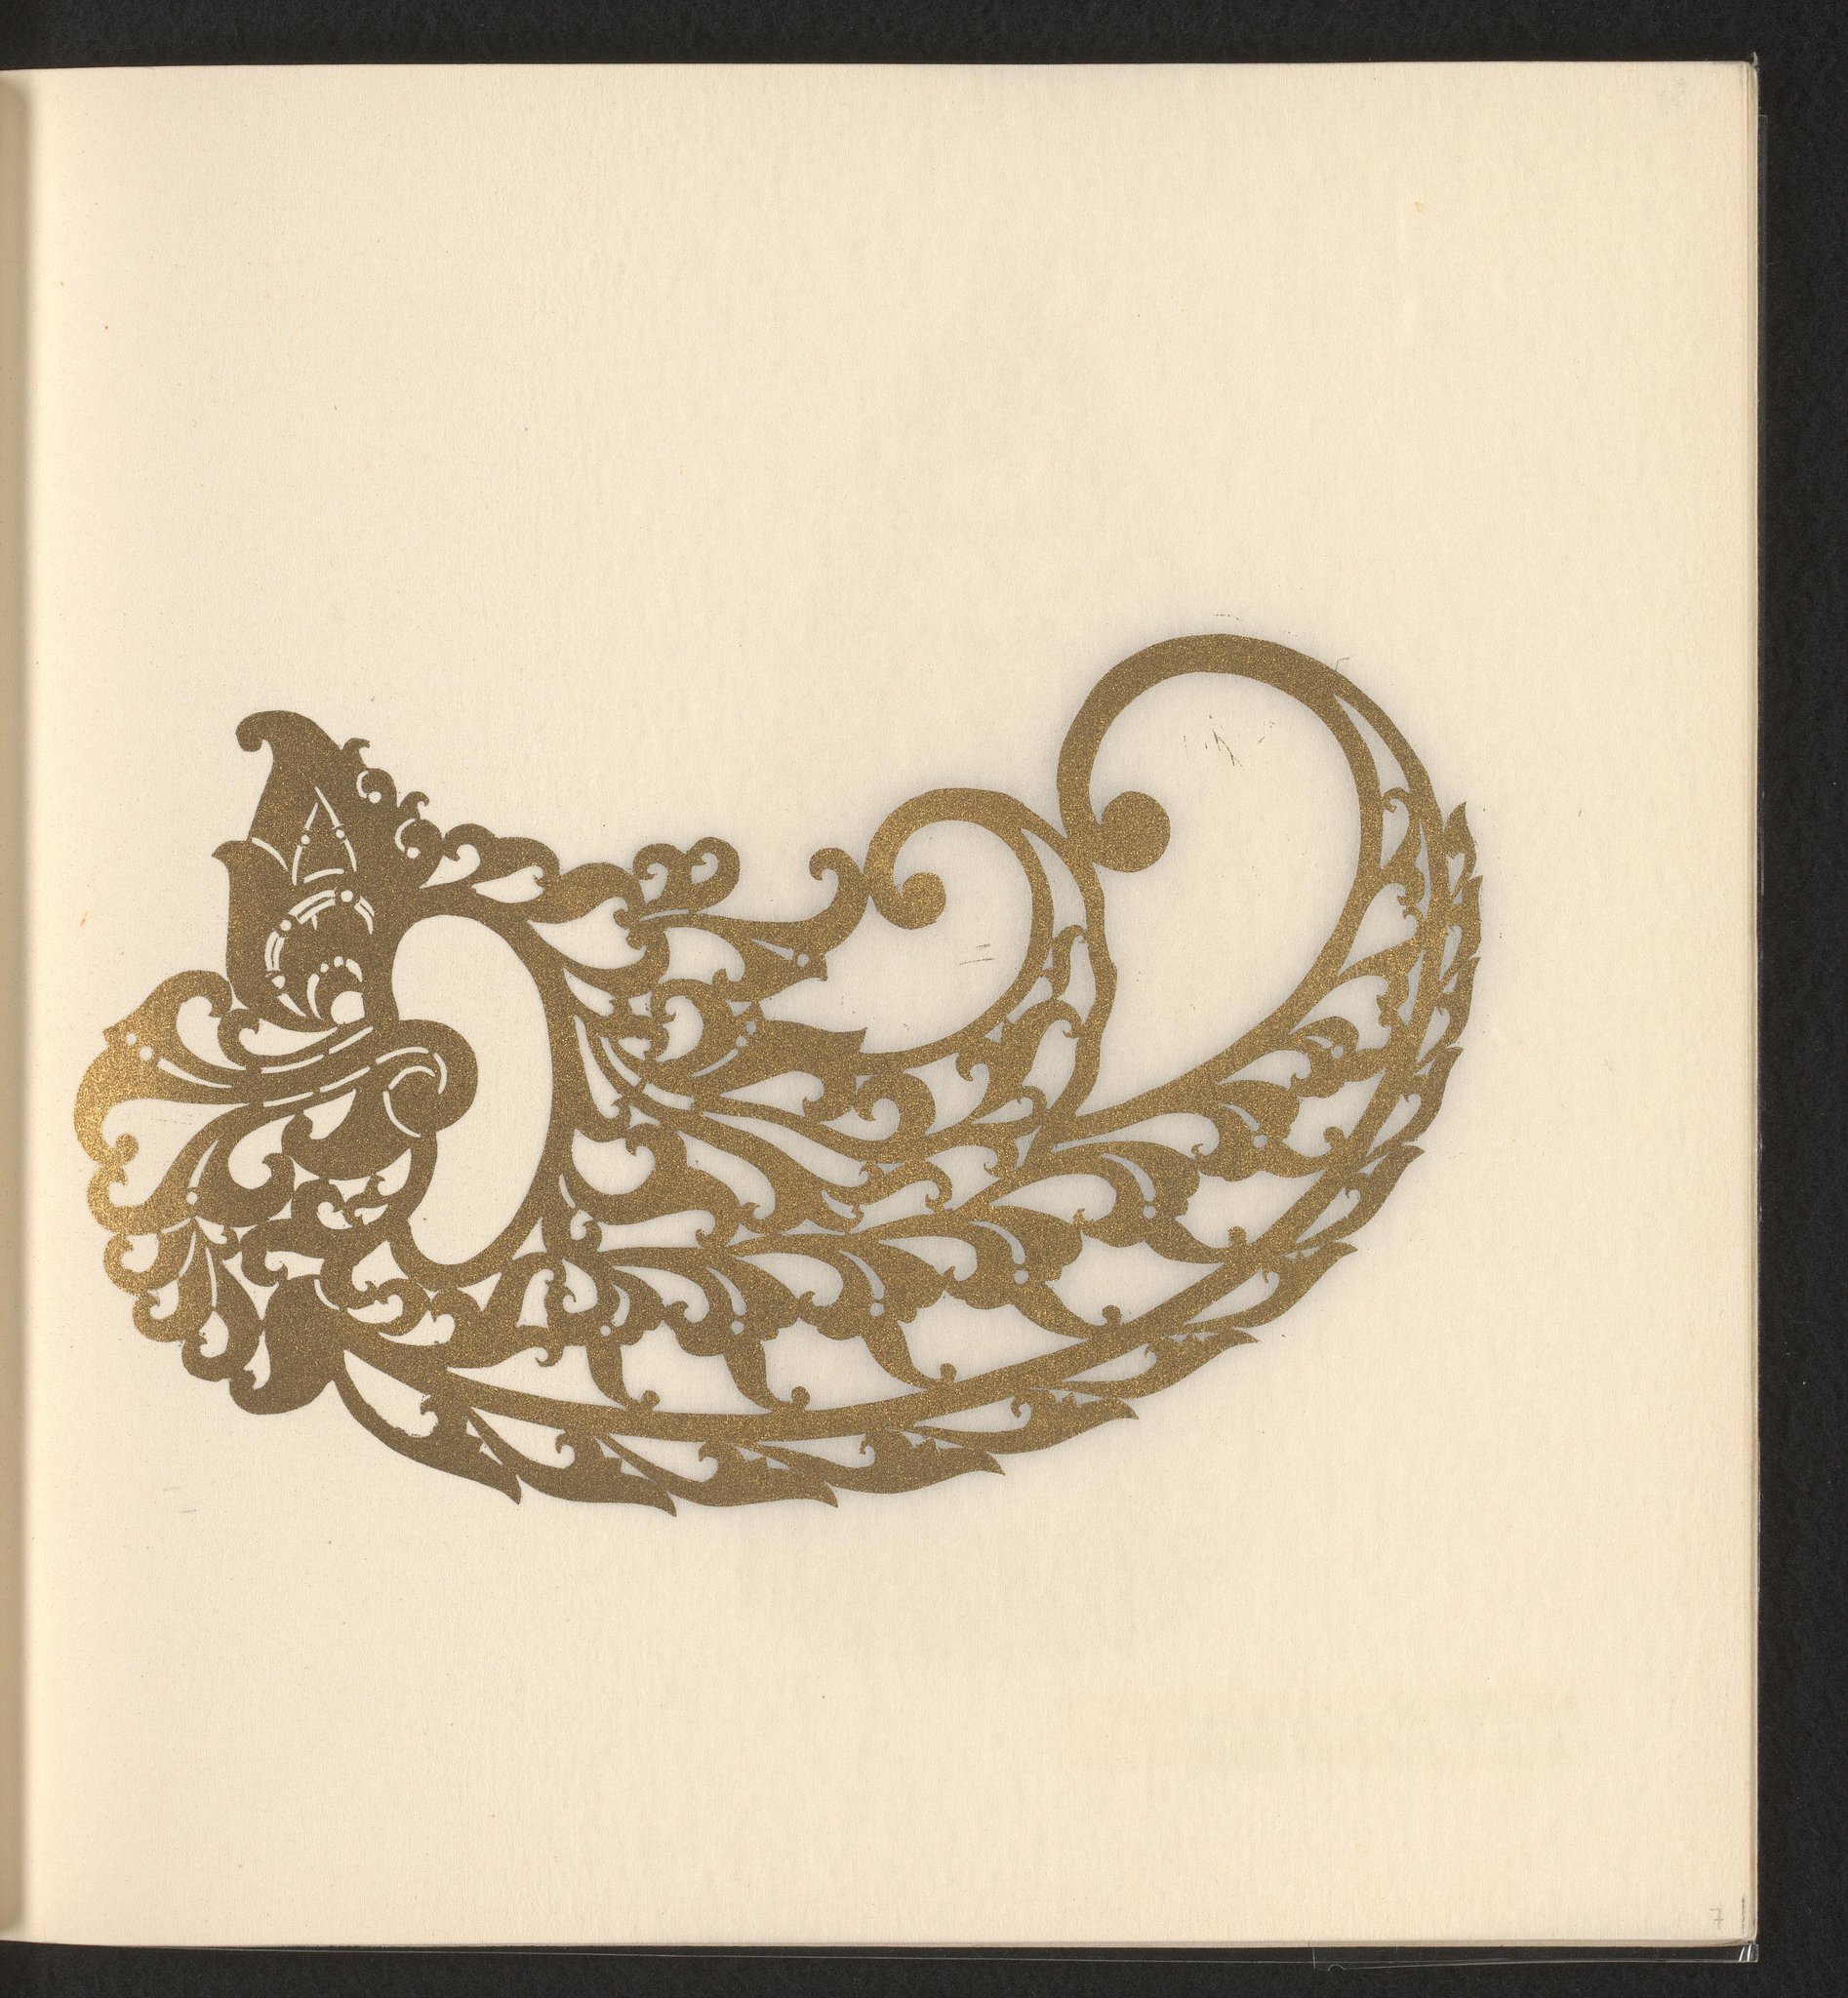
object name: print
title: Hoofdtooi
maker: reijer stolk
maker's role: draughtsman, print maker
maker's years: 1896-1945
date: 1942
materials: paper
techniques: woodcut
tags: head-gear, indonesia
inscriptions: date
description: Onderdeel van album 'Tien bladen sierkunst uit ons Oost-Indië'.